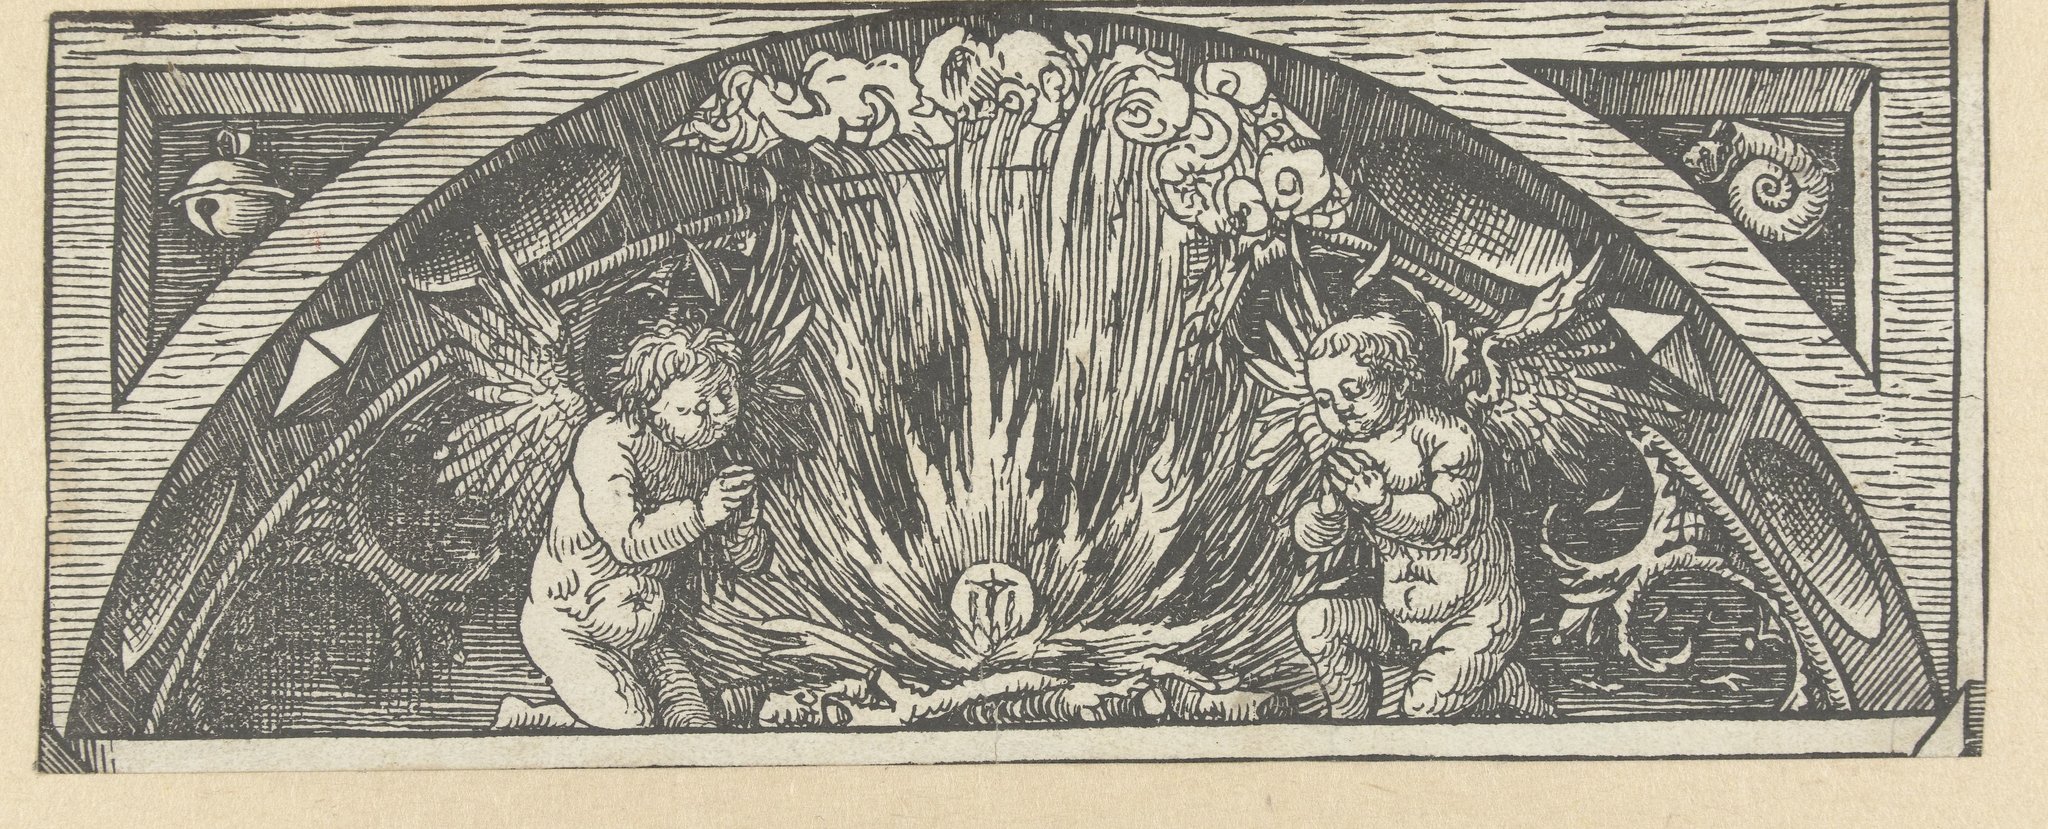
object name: print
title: De hostie in het vuur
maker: jacob cornelisz van oostsanen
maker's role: draughtsman, painter, print maker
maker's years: 1475-1533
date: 1513-1523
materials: paper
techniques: woodcut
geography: low countries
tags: amsterdam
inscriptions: collector's mark: Lugt 240